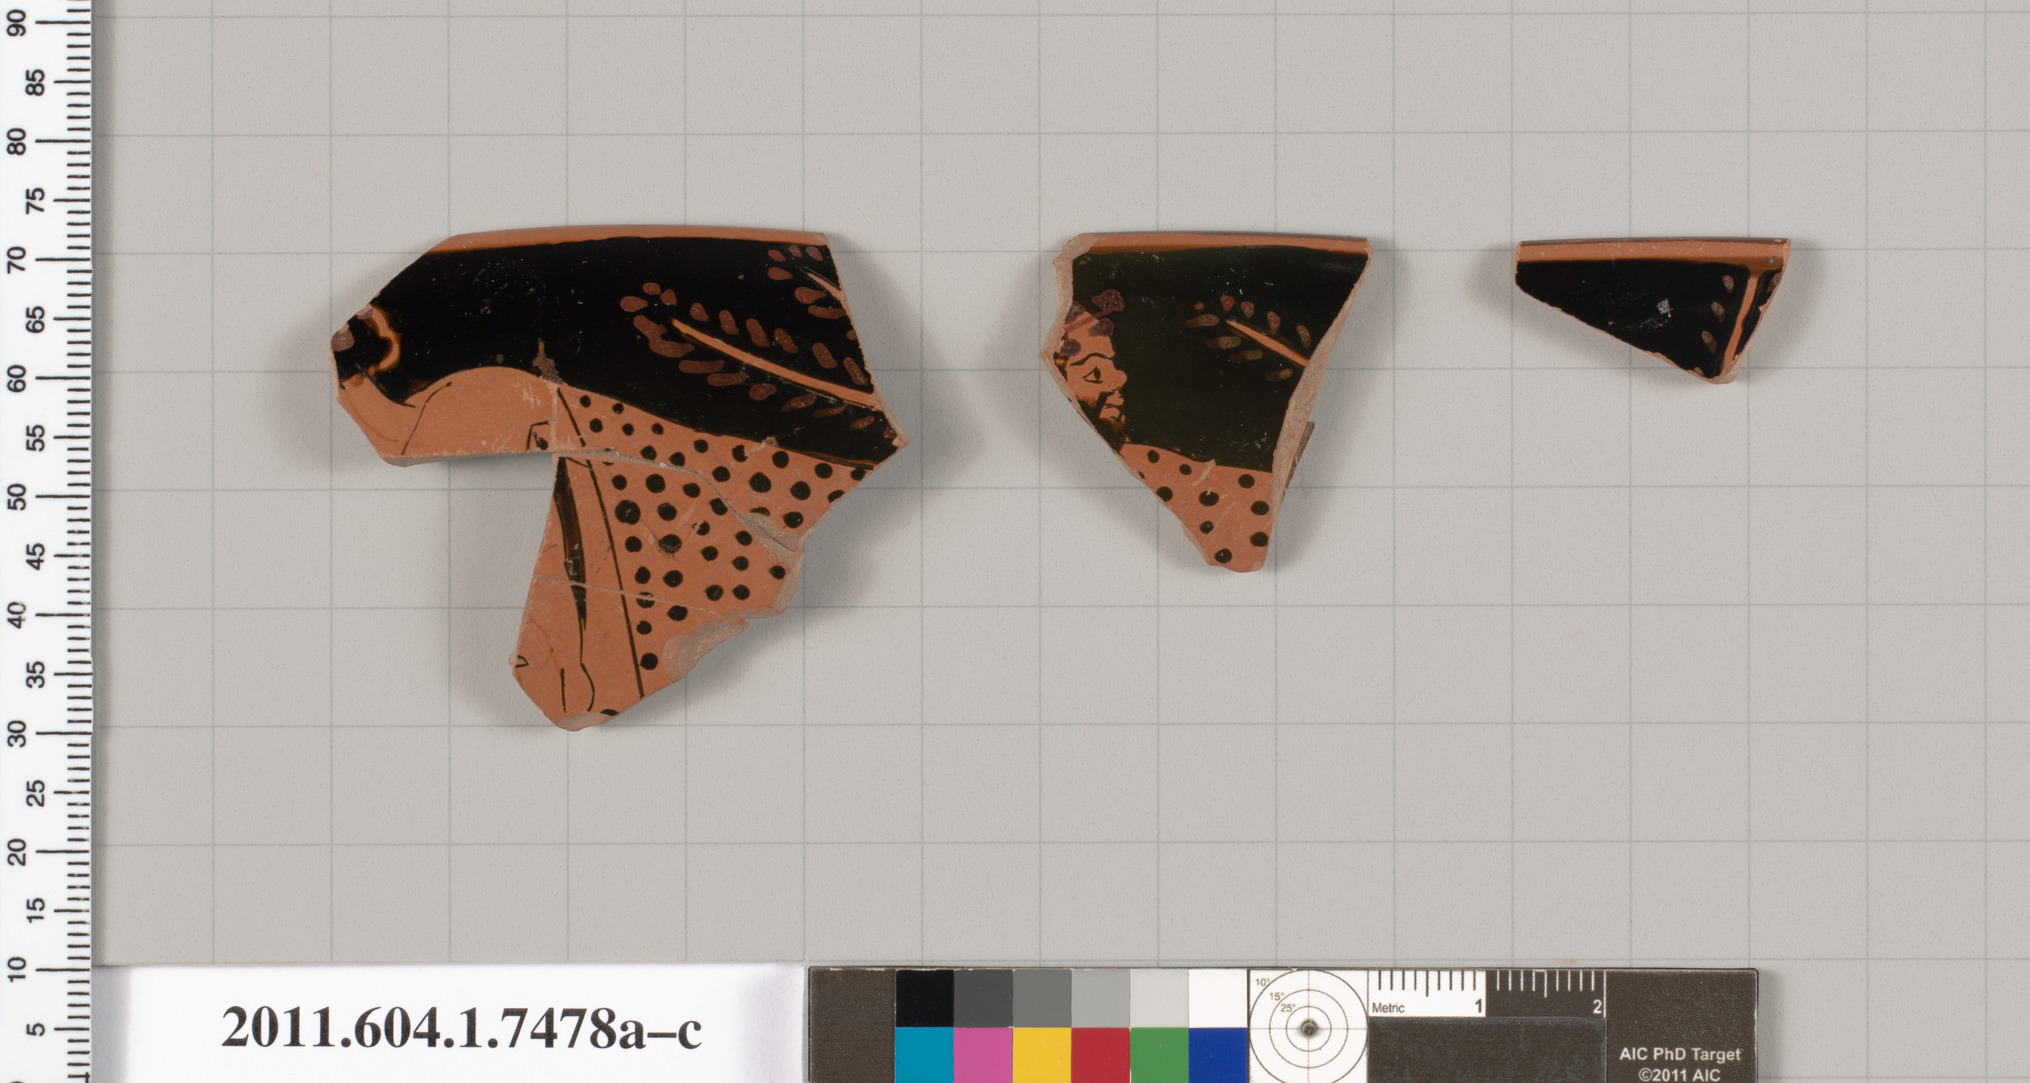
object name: kylix fragment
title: Terracotta rim fragments of a kylix (drinking cup)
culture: greek, attic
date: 470-460 BCE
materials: terracotta